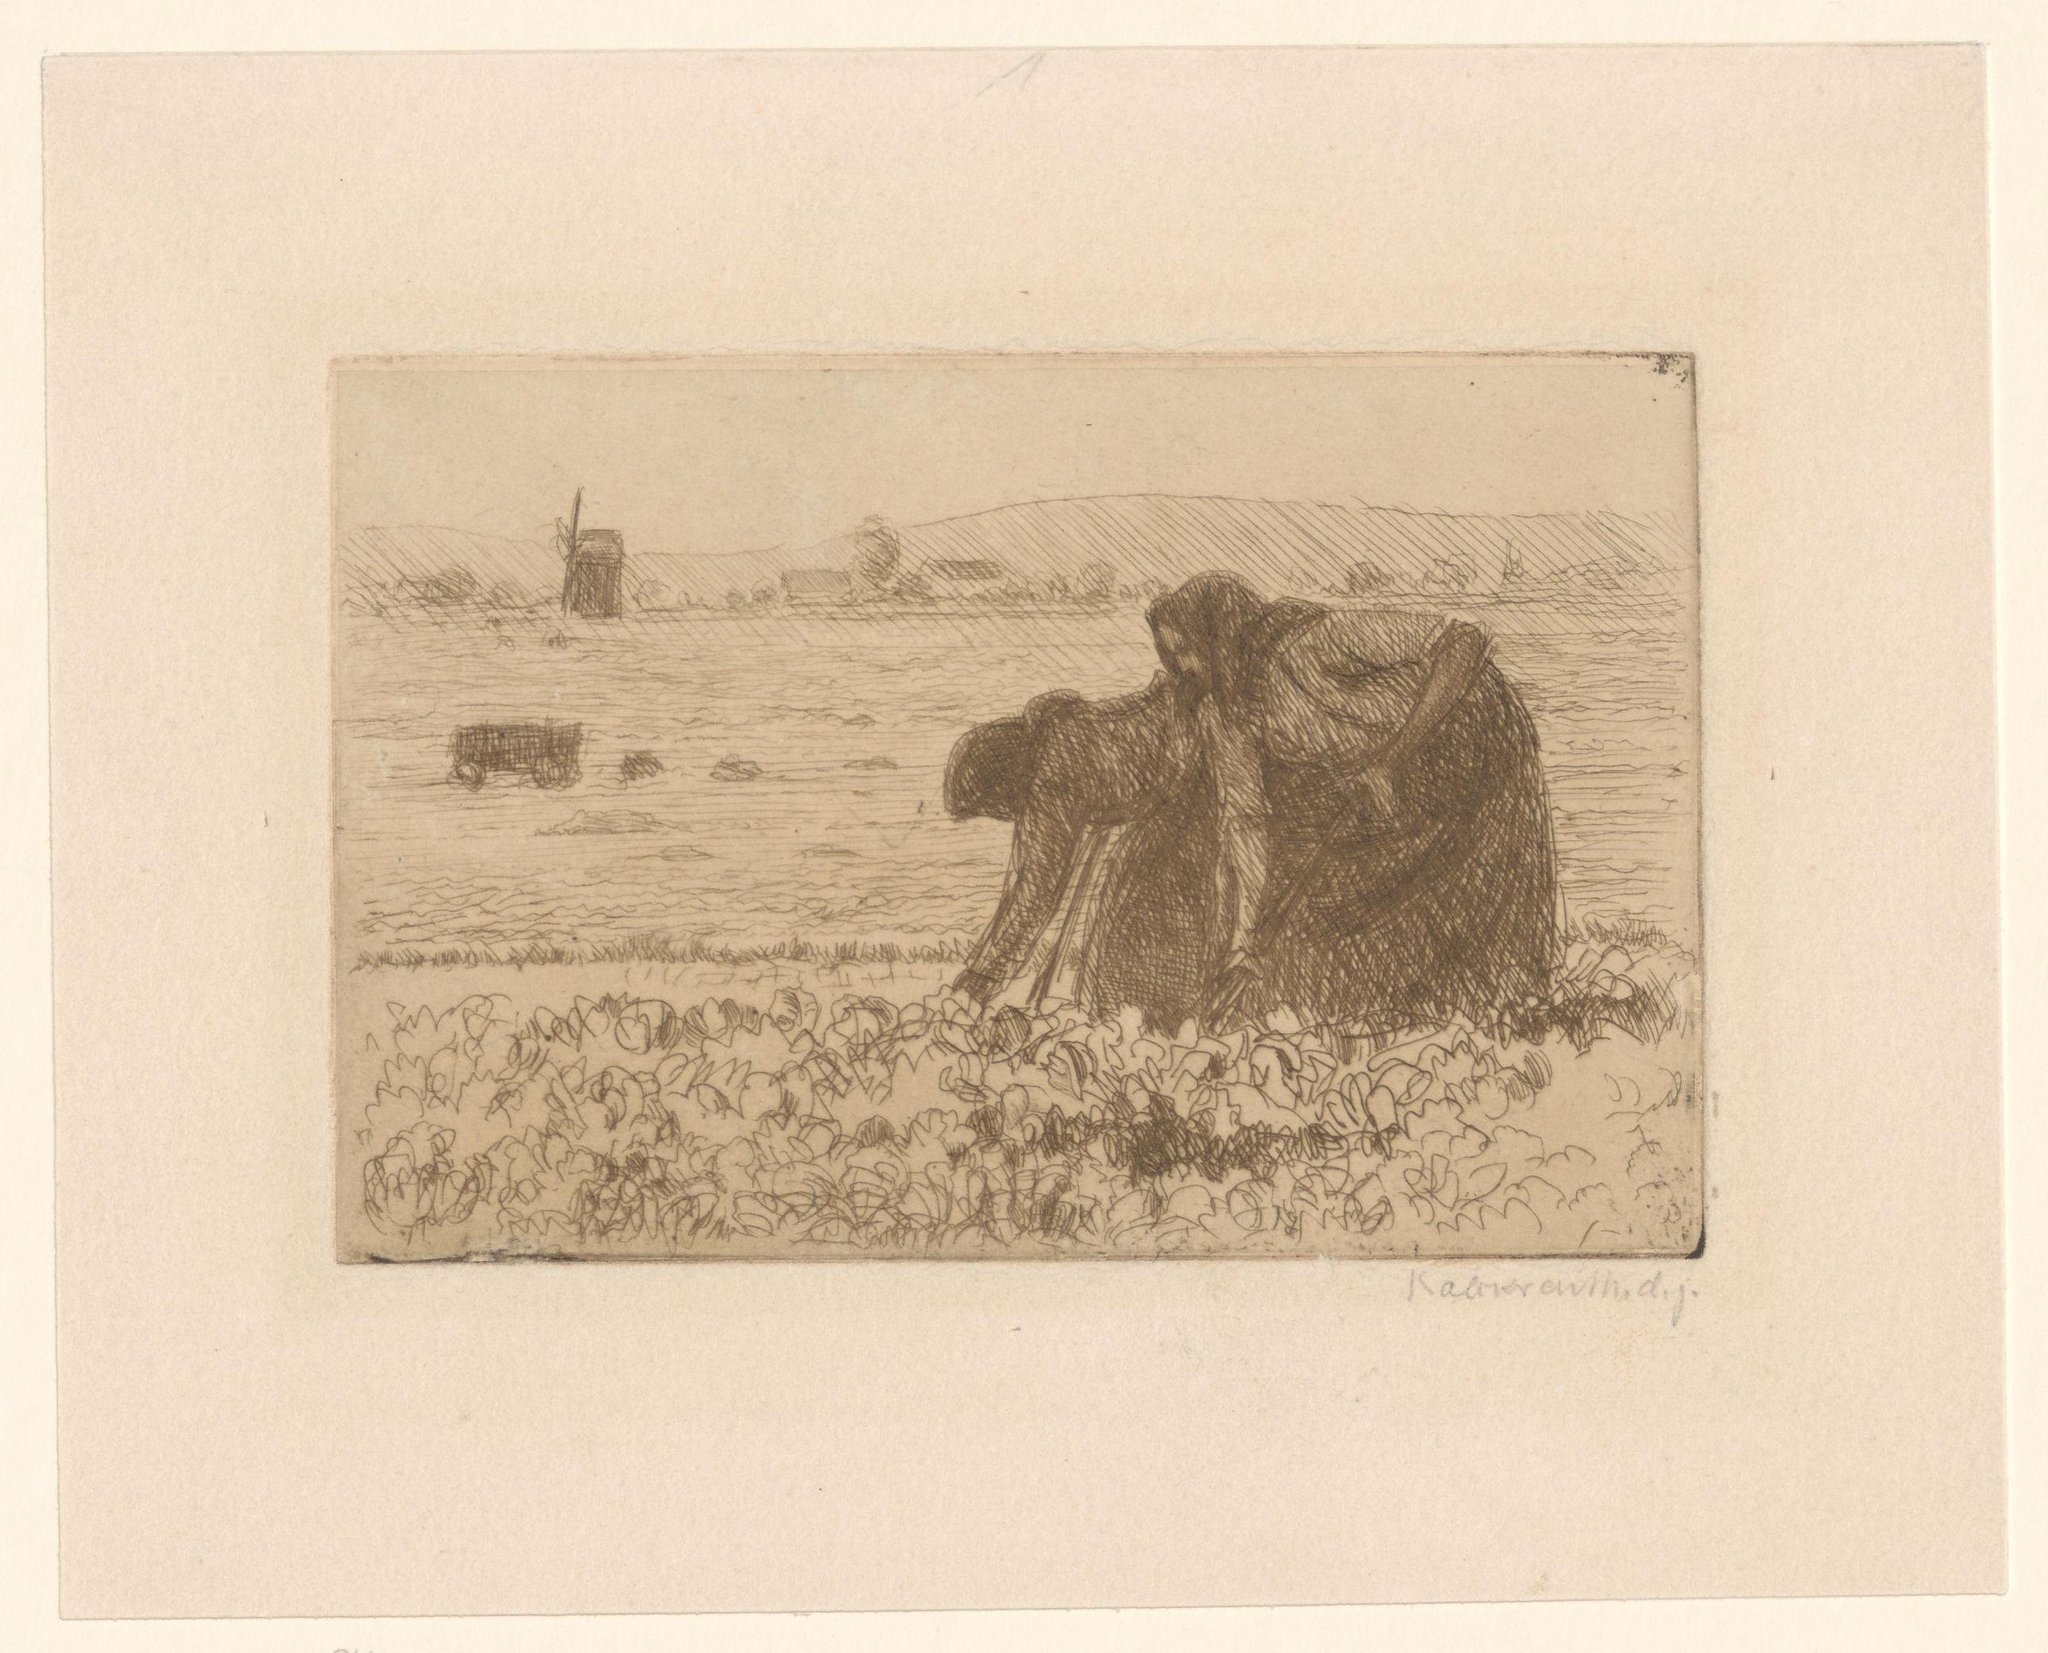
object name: print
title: Arenleessters aan het werk in het veld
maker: leopold von kalckreuth (graaf)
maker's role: print maker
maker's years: 1855-1928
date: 1865-1928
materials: paper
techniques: etching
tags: gleaning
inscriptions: collector's mark: Lugt 2228, collector's mark, collector's mark: Lugt 2113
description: Prent mogelijk gebaseerd op Jean-François Millet's schilderij 'Arenleessters' uit 1857, dat zich in het Musée d'Orsay bevindt.